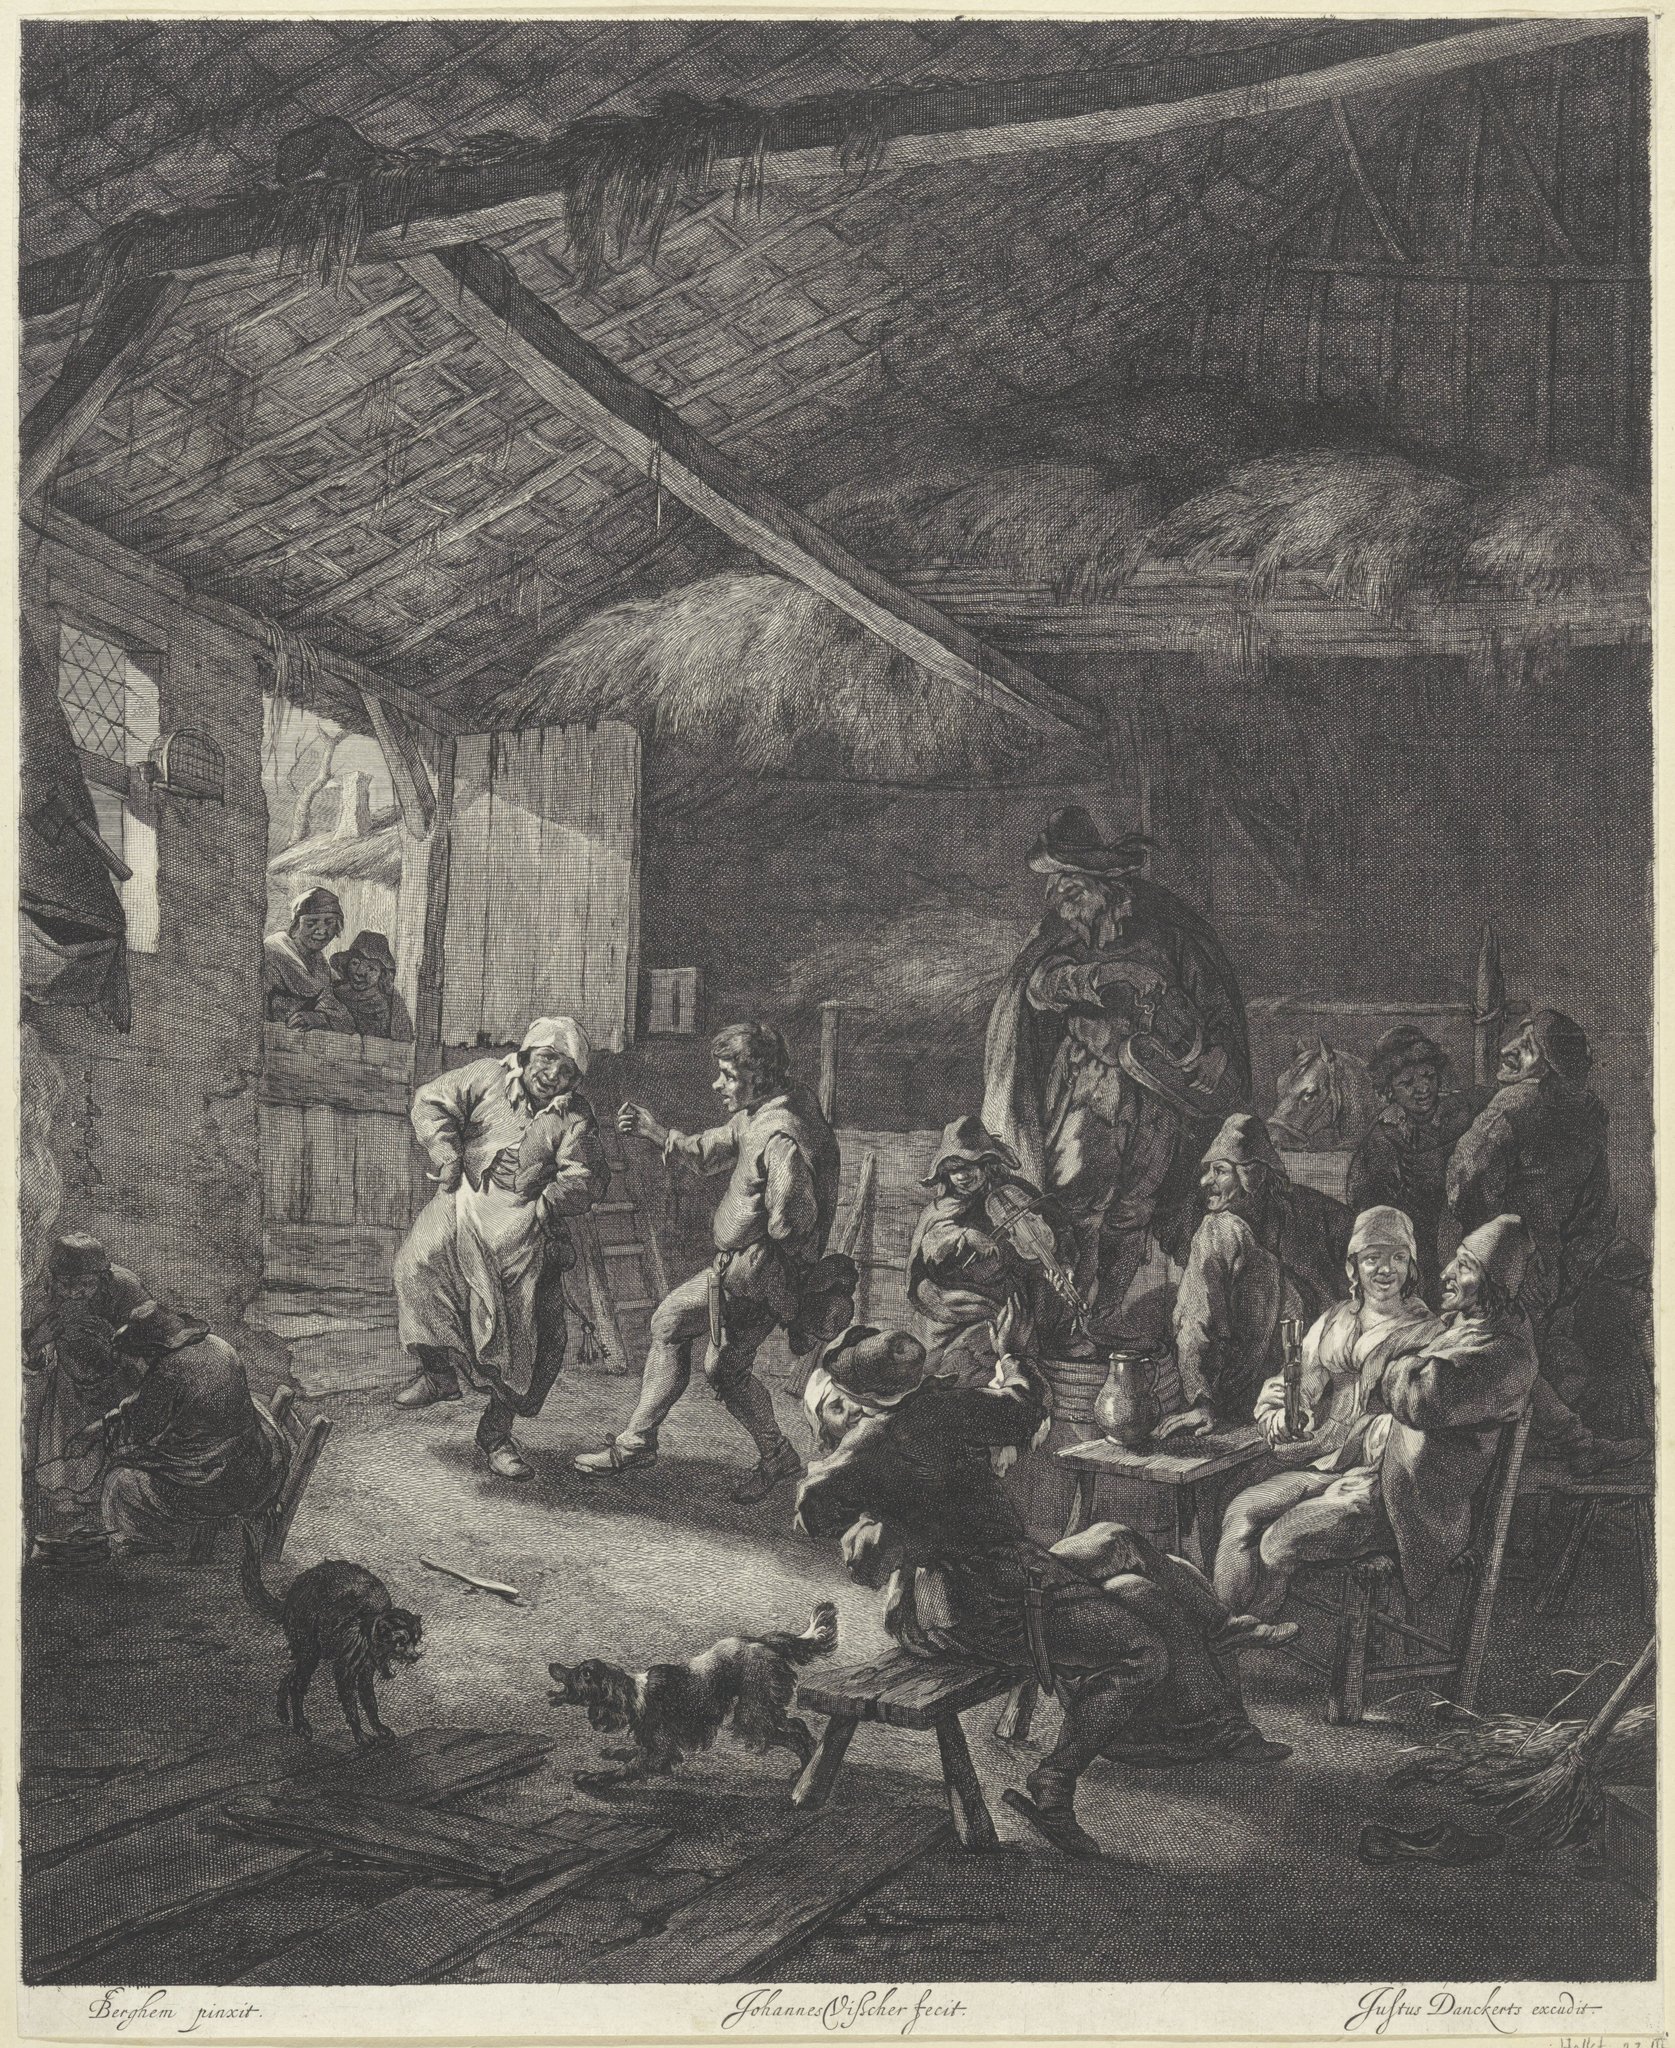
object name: print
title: Boerendans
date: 1643-1701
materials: paper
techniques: engraving, etching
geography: amsterdam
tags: dancing, (lovers) kissing each other, shed, more than one musician with instrument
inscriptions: collector's mark: Lugt 240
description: In een schuur wordt onder begeleiding van het spel van een violist en een man met een draailier uitbundig gedanst door een koppel. Anderen kijken toe, roken hun pijp of voeren een gesprek. Op de voorgrond een zoenend paar.